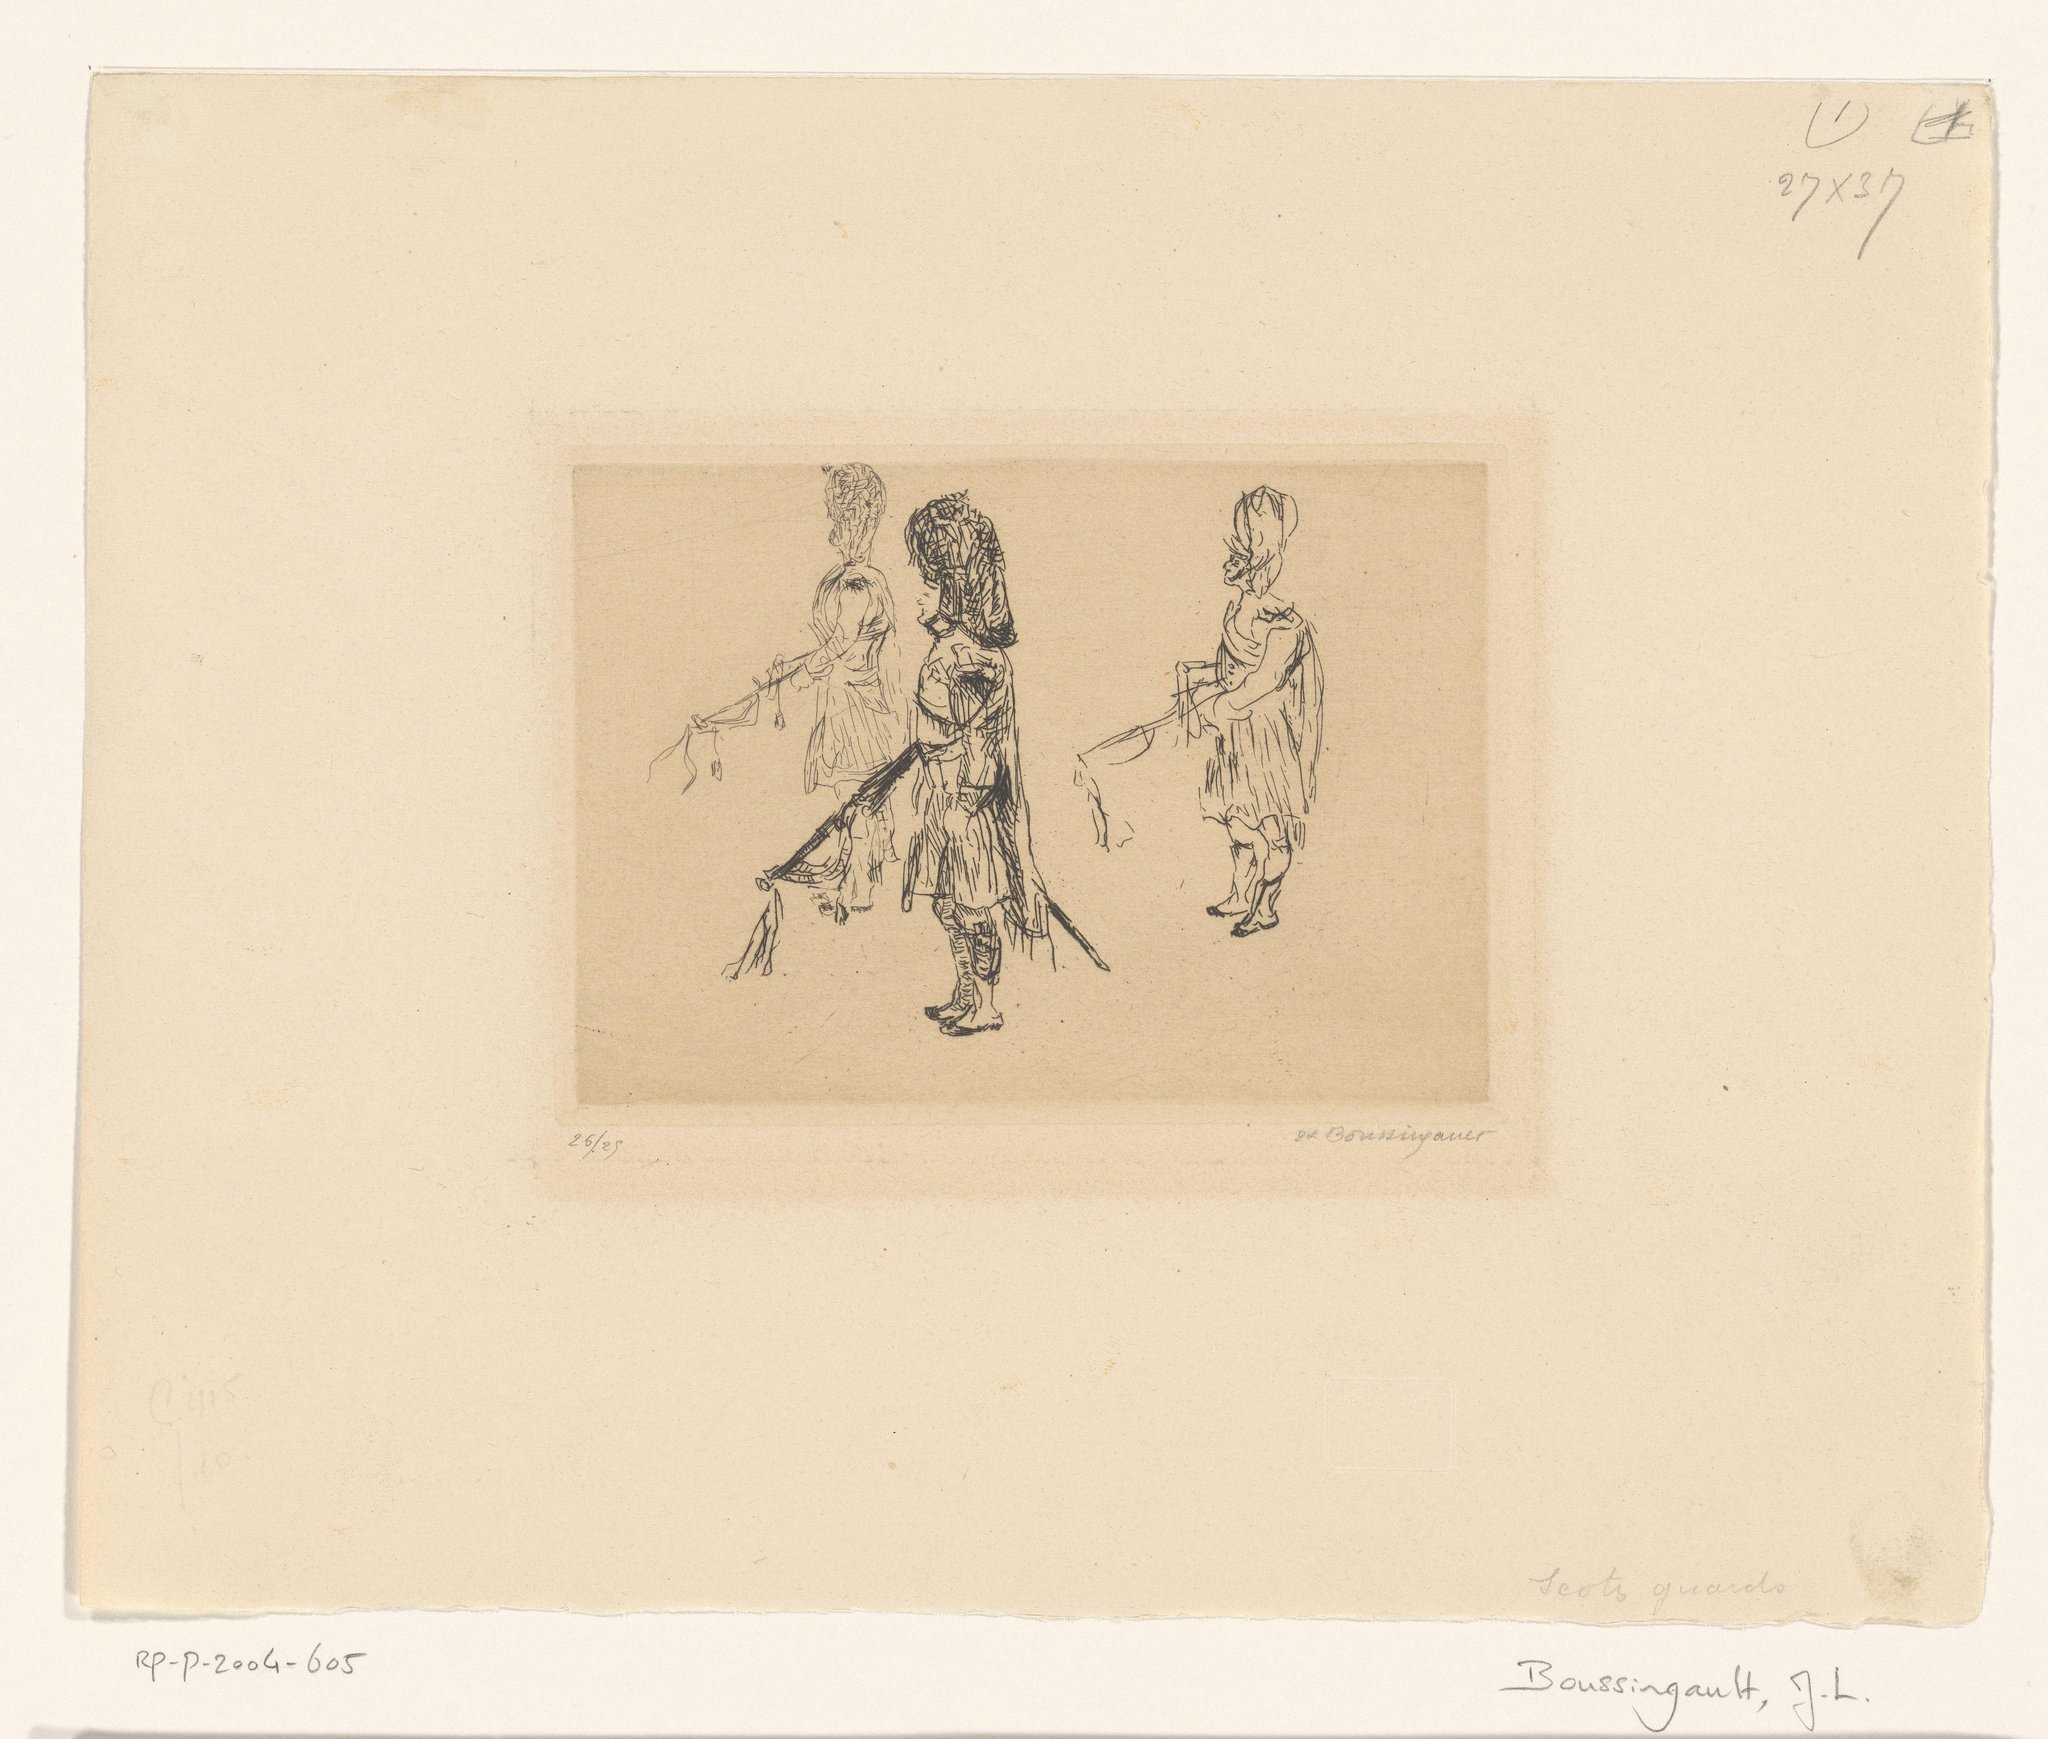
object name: print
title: Scots guards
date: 1929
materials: paper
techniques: etching, intaglio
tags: guard duty, keeping sentry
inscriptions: collector's mark: Lugt 2228, check stamp: ‘Jacquart/ Éditeur/ Paris’